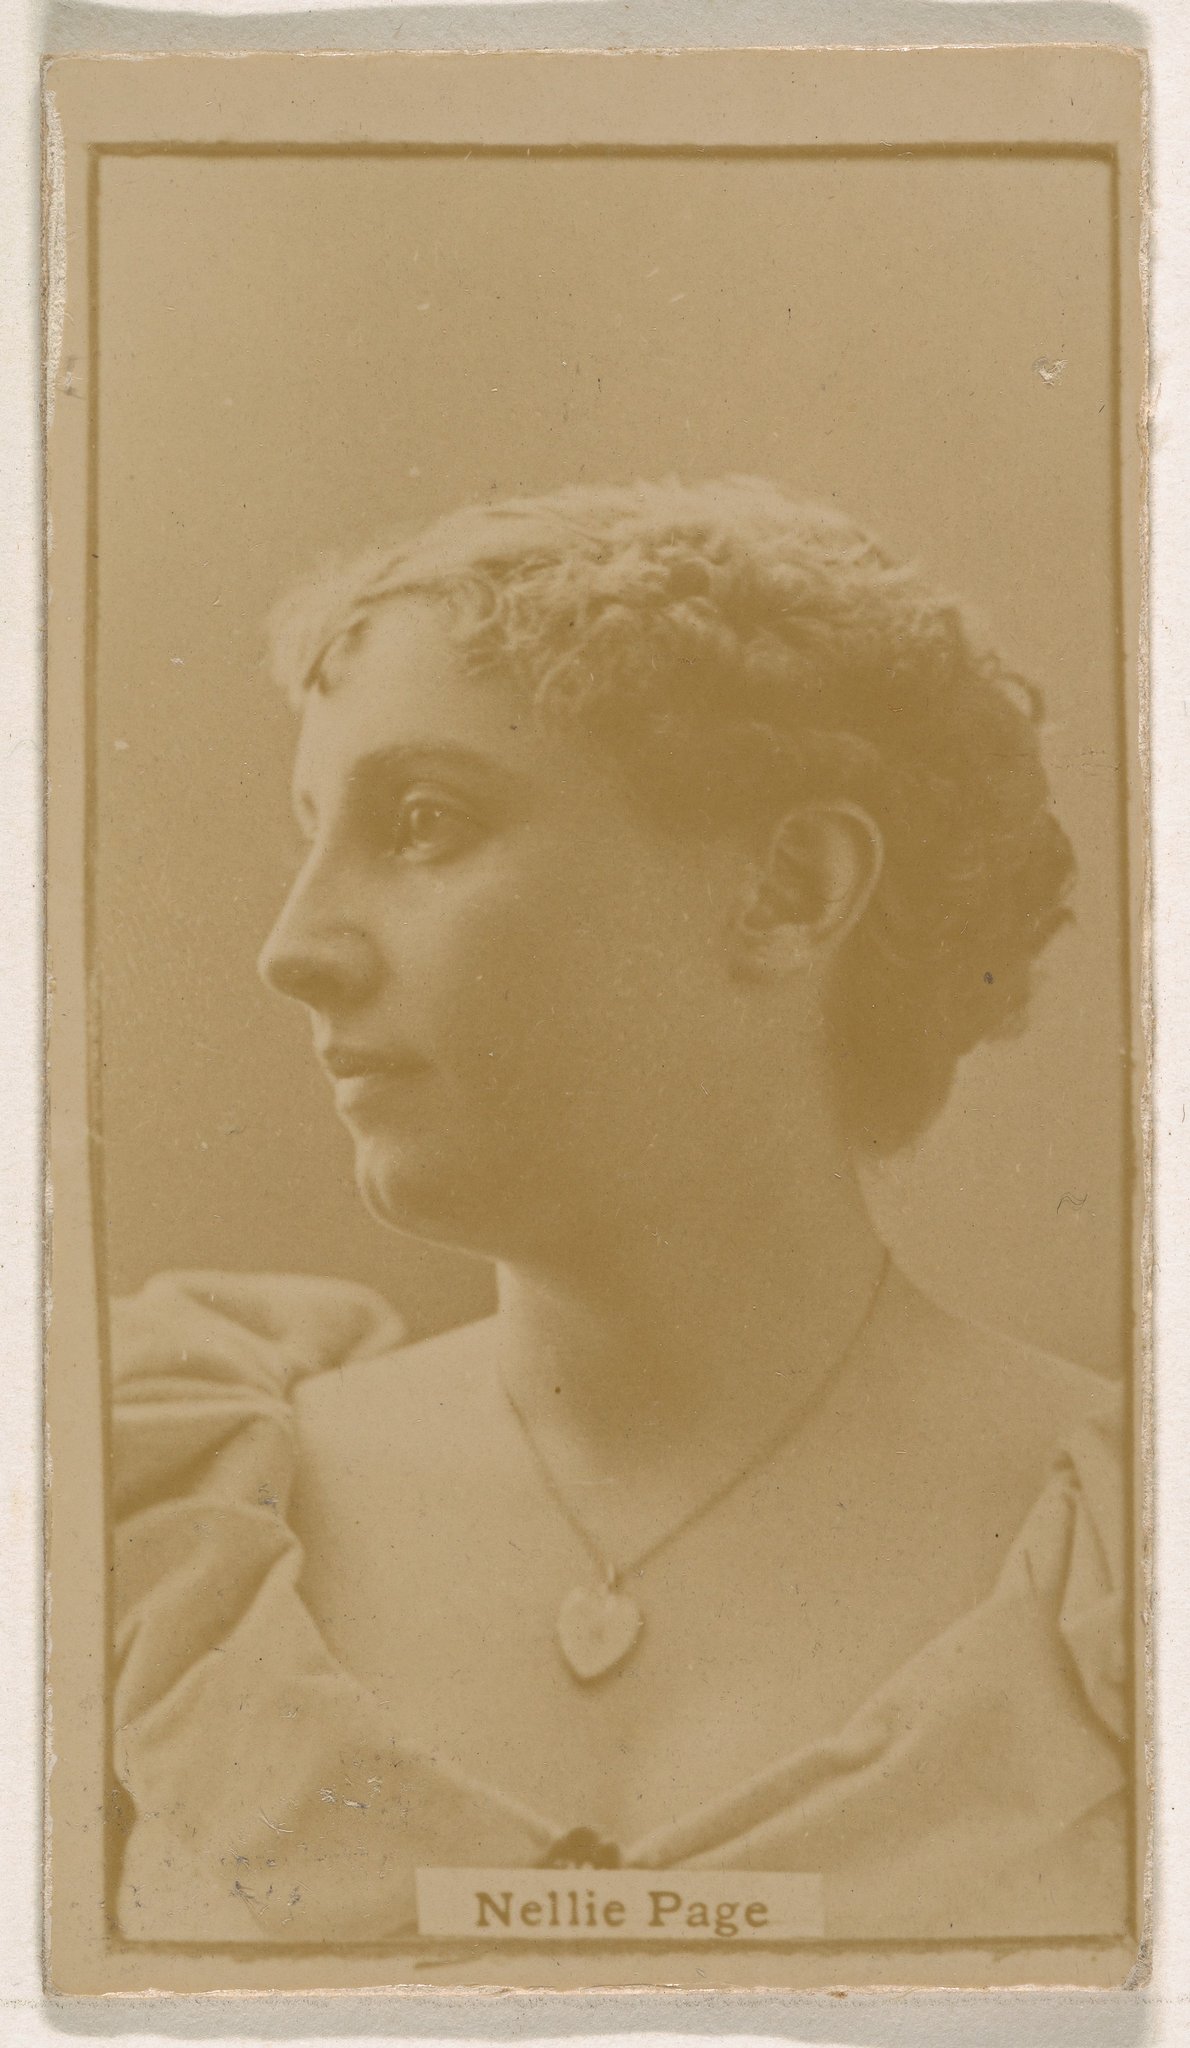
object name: photograph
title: Nellie Page, from the Actresses series (N245) issued by Kinney Brothers to promote Sweet Caporal Cigarettes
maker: kinney brothers tobacco company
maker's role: publisher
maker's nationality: american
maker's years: 1869-2011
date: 1890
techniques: albumen silver print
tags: women,actresses